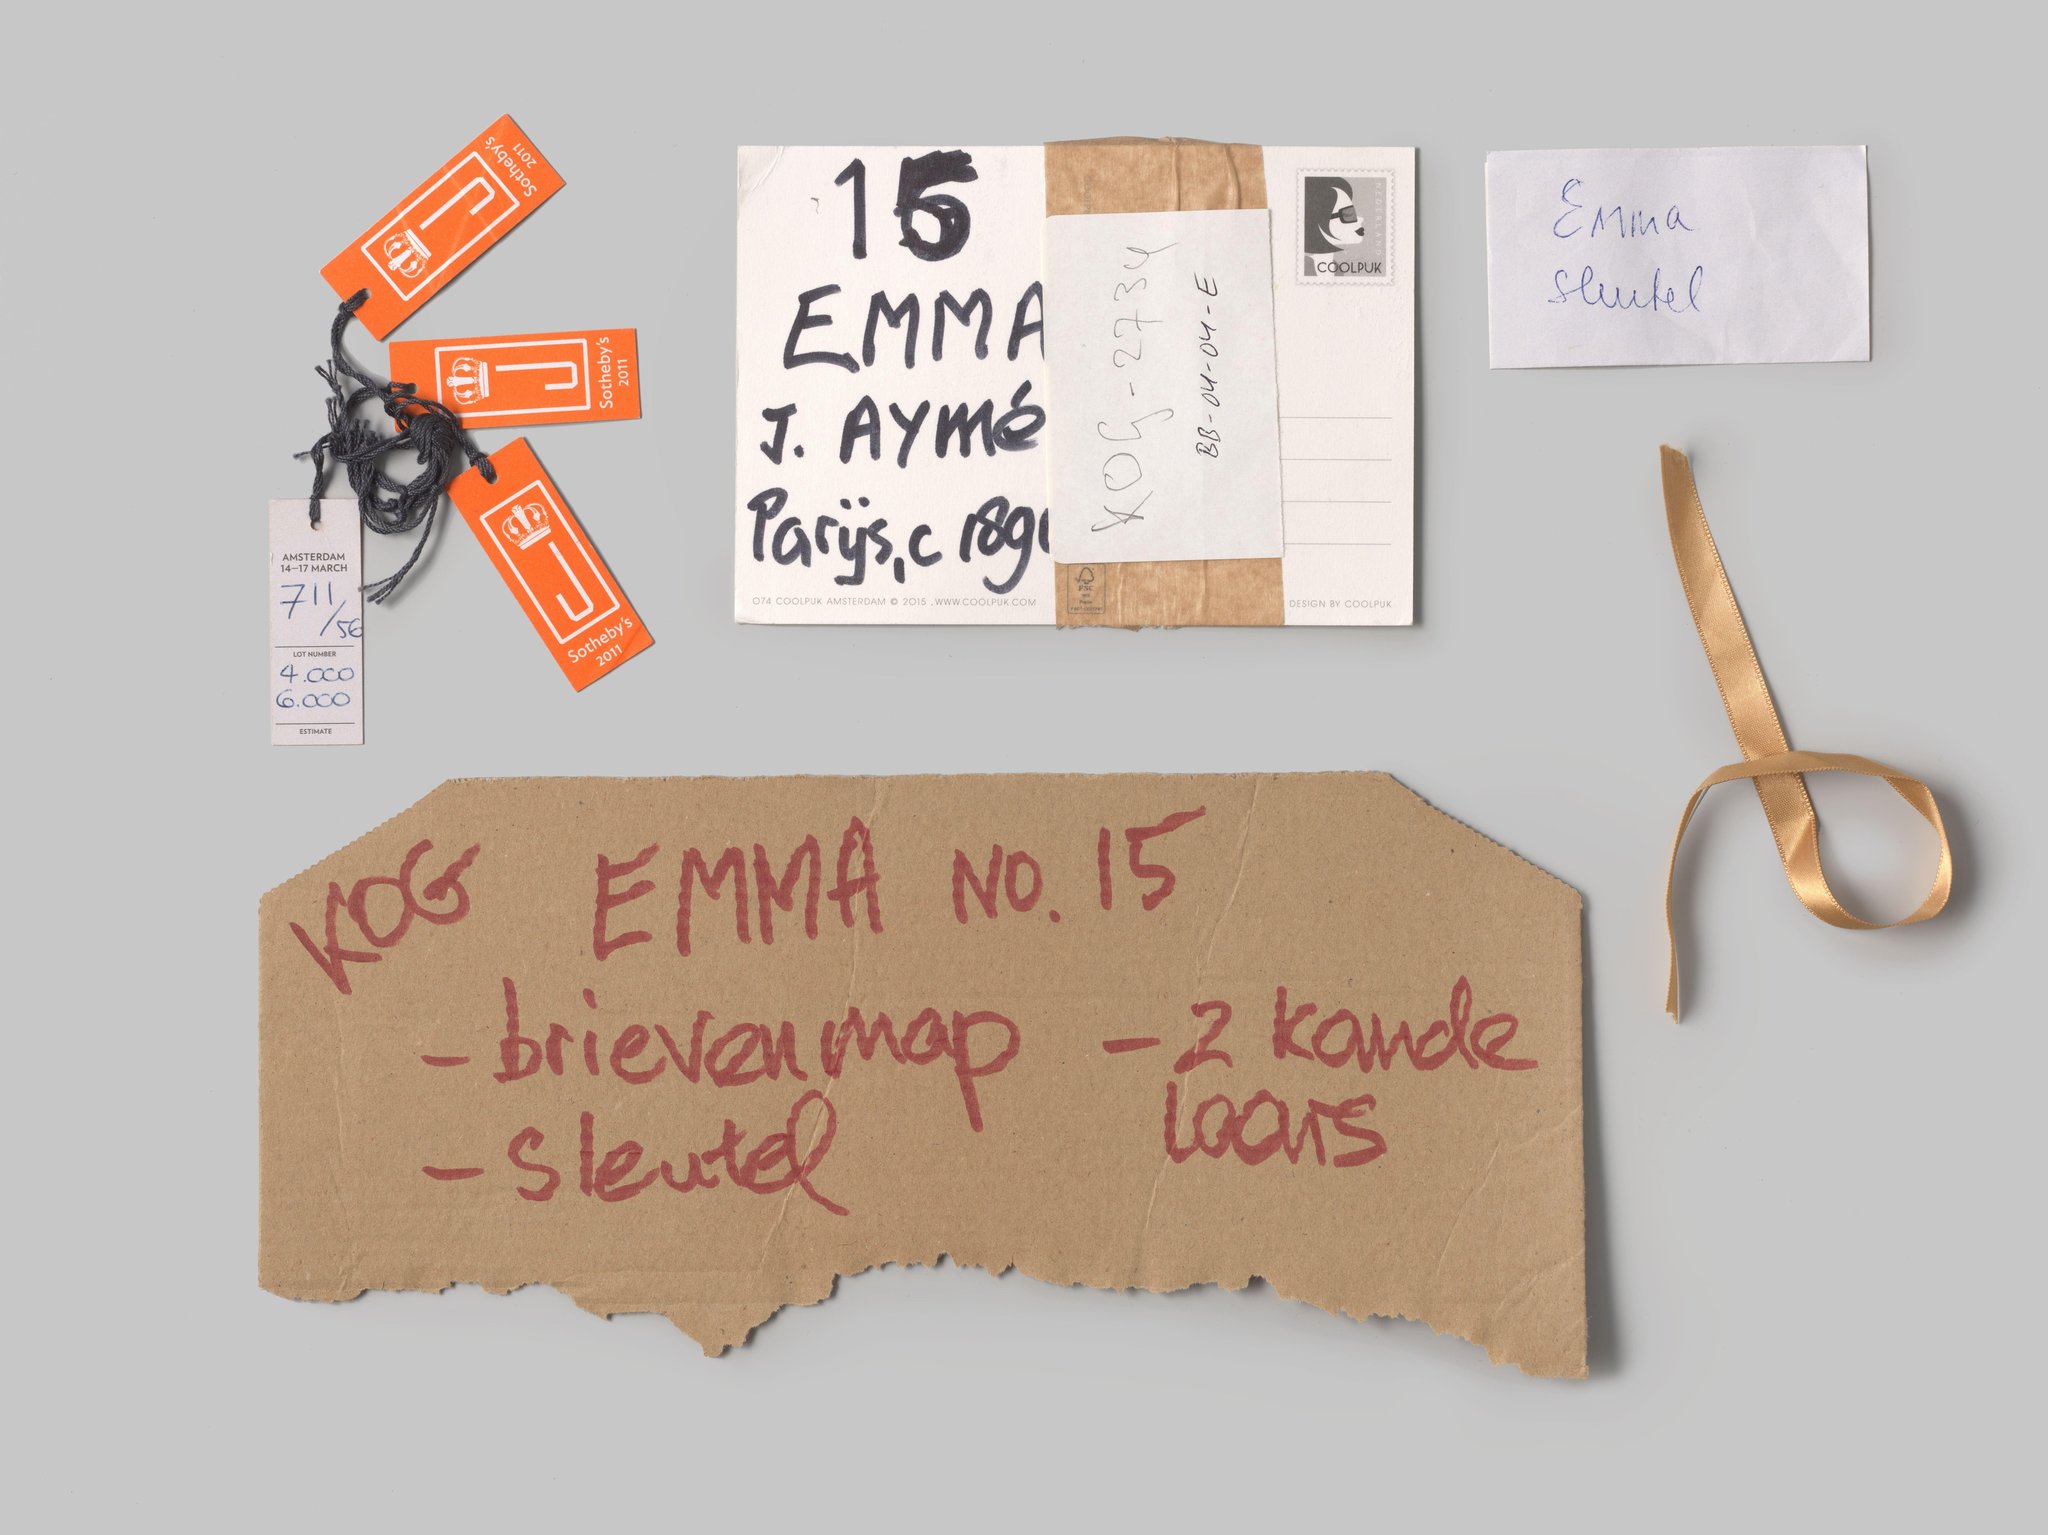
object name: reisnecessaire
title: Brievenmap, sleutel en ansichtkaart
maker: joseph aymé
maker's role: silversmith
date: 1942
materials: iron, plastic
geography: paris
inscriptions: maker's mark: ‘JA’, alloy mark, maker's mark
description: Eigentijds doorzichtig plastic etui bevat paars beklede brievenmap, de sleutel en een ansichtkaart